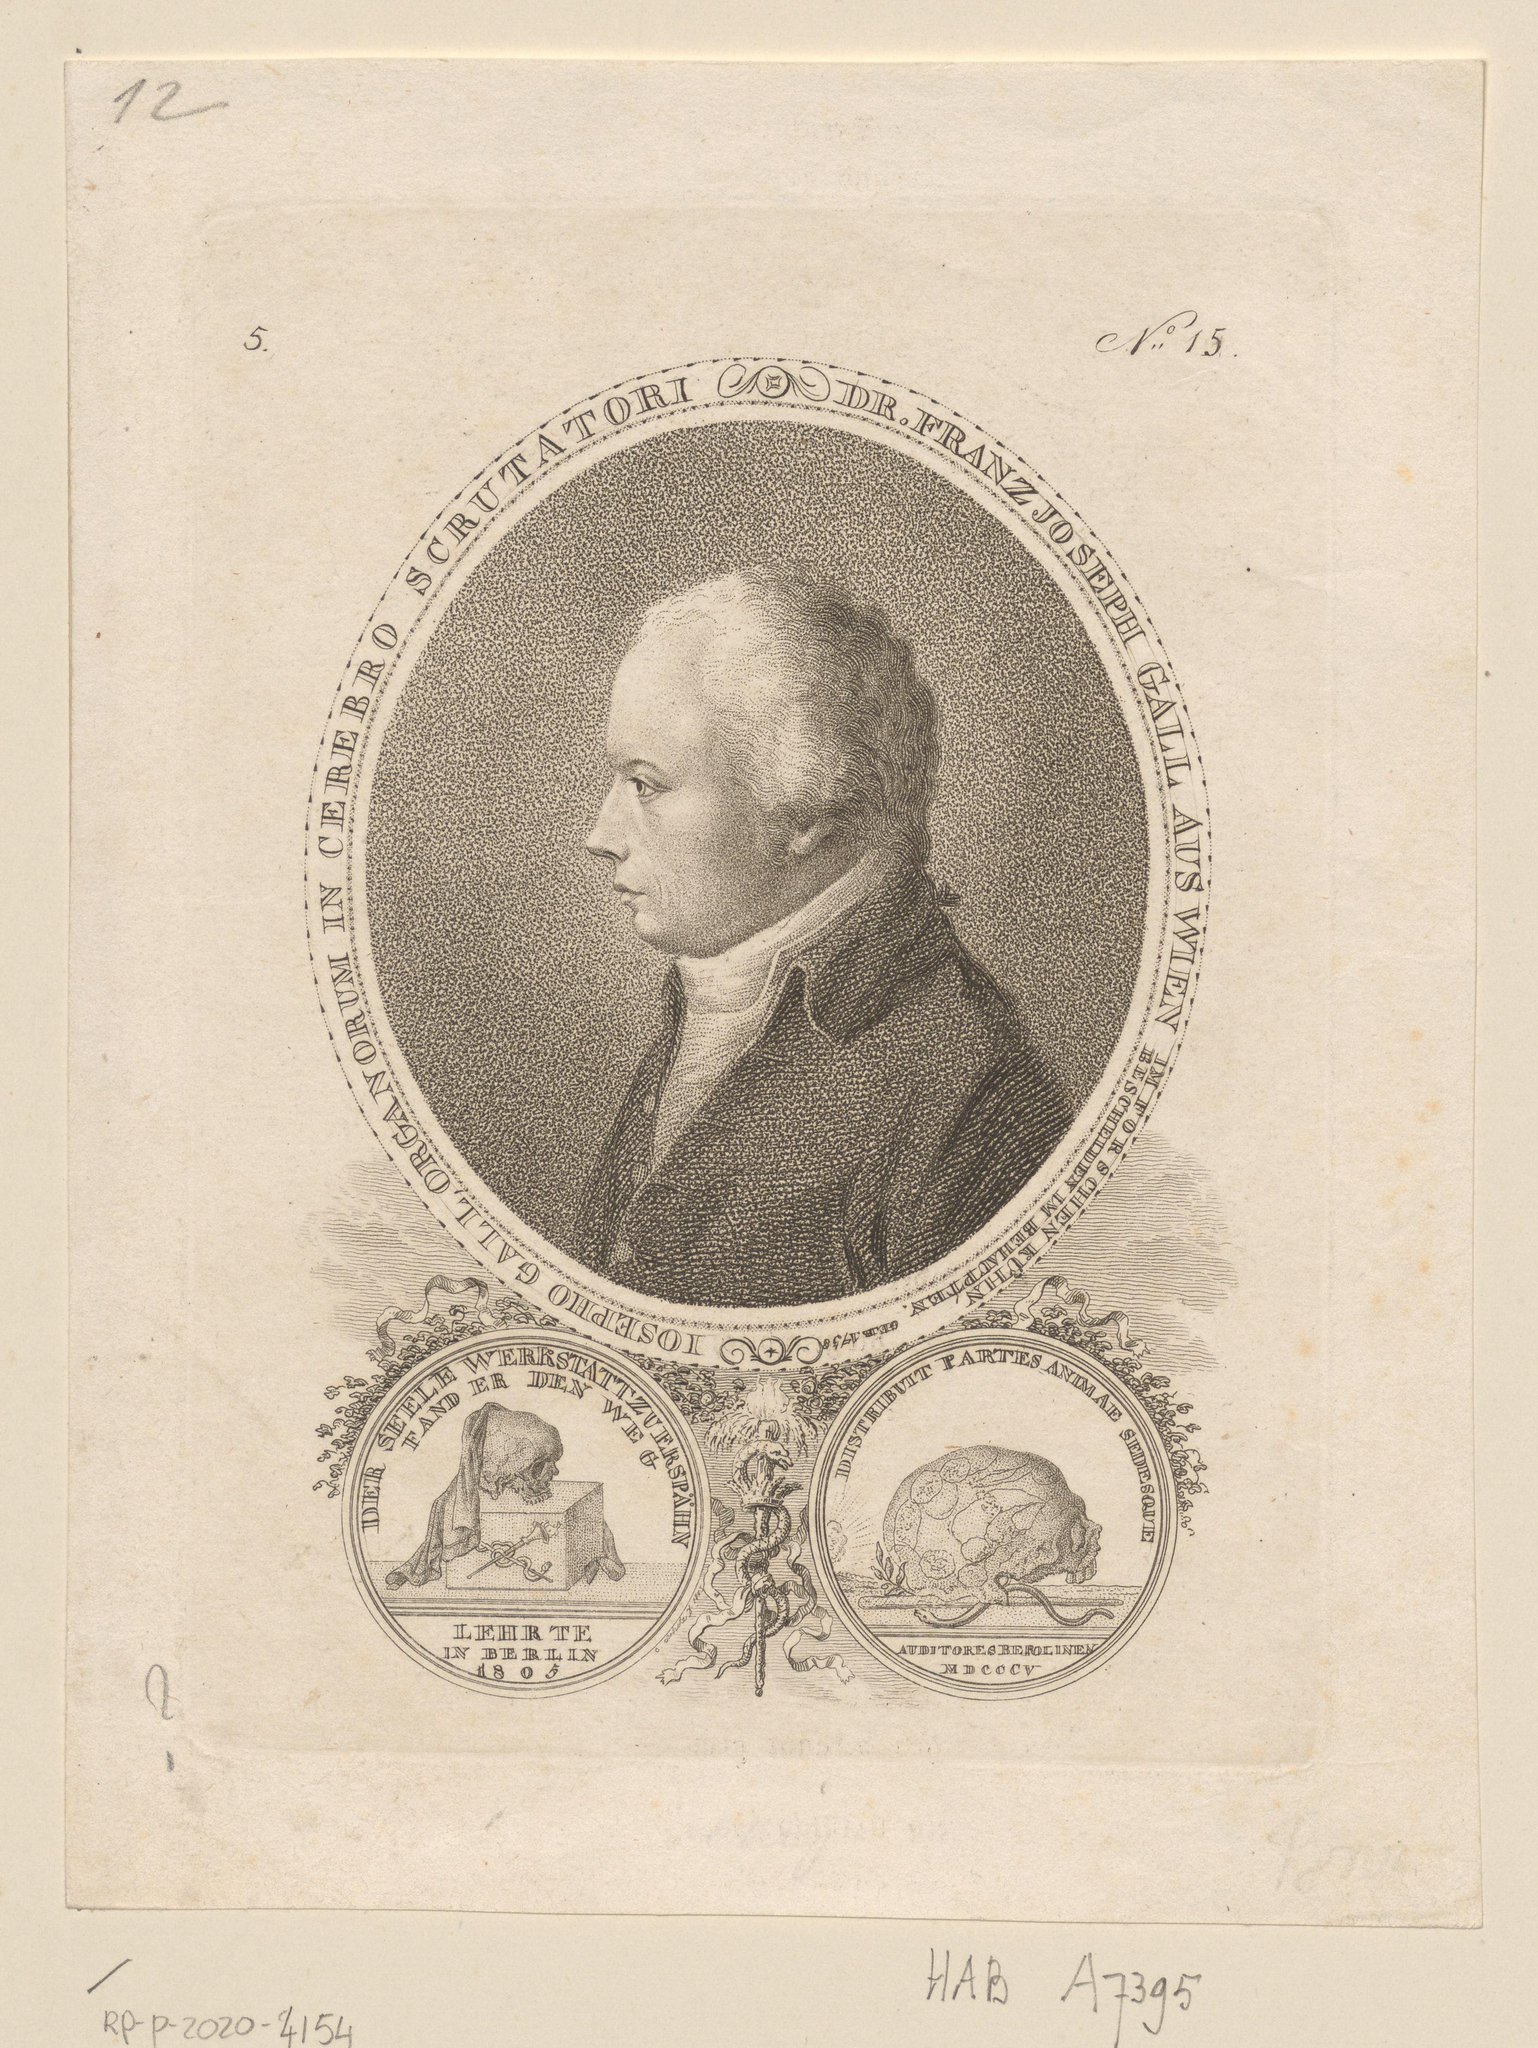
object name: print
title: Portret van Franz Joseph Gall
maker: christian schule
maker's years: 1764-1816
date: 1805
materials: paper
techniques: engraving, etching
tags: historical persons, physician, doctor (+ portrait of scholar, scientist)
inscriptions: date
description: Tekst in het Duits en het Engels in de marges. Tekst in het Duits en het Latijn in de omlijsting. Genummerd: 15. Genummerd: 5.